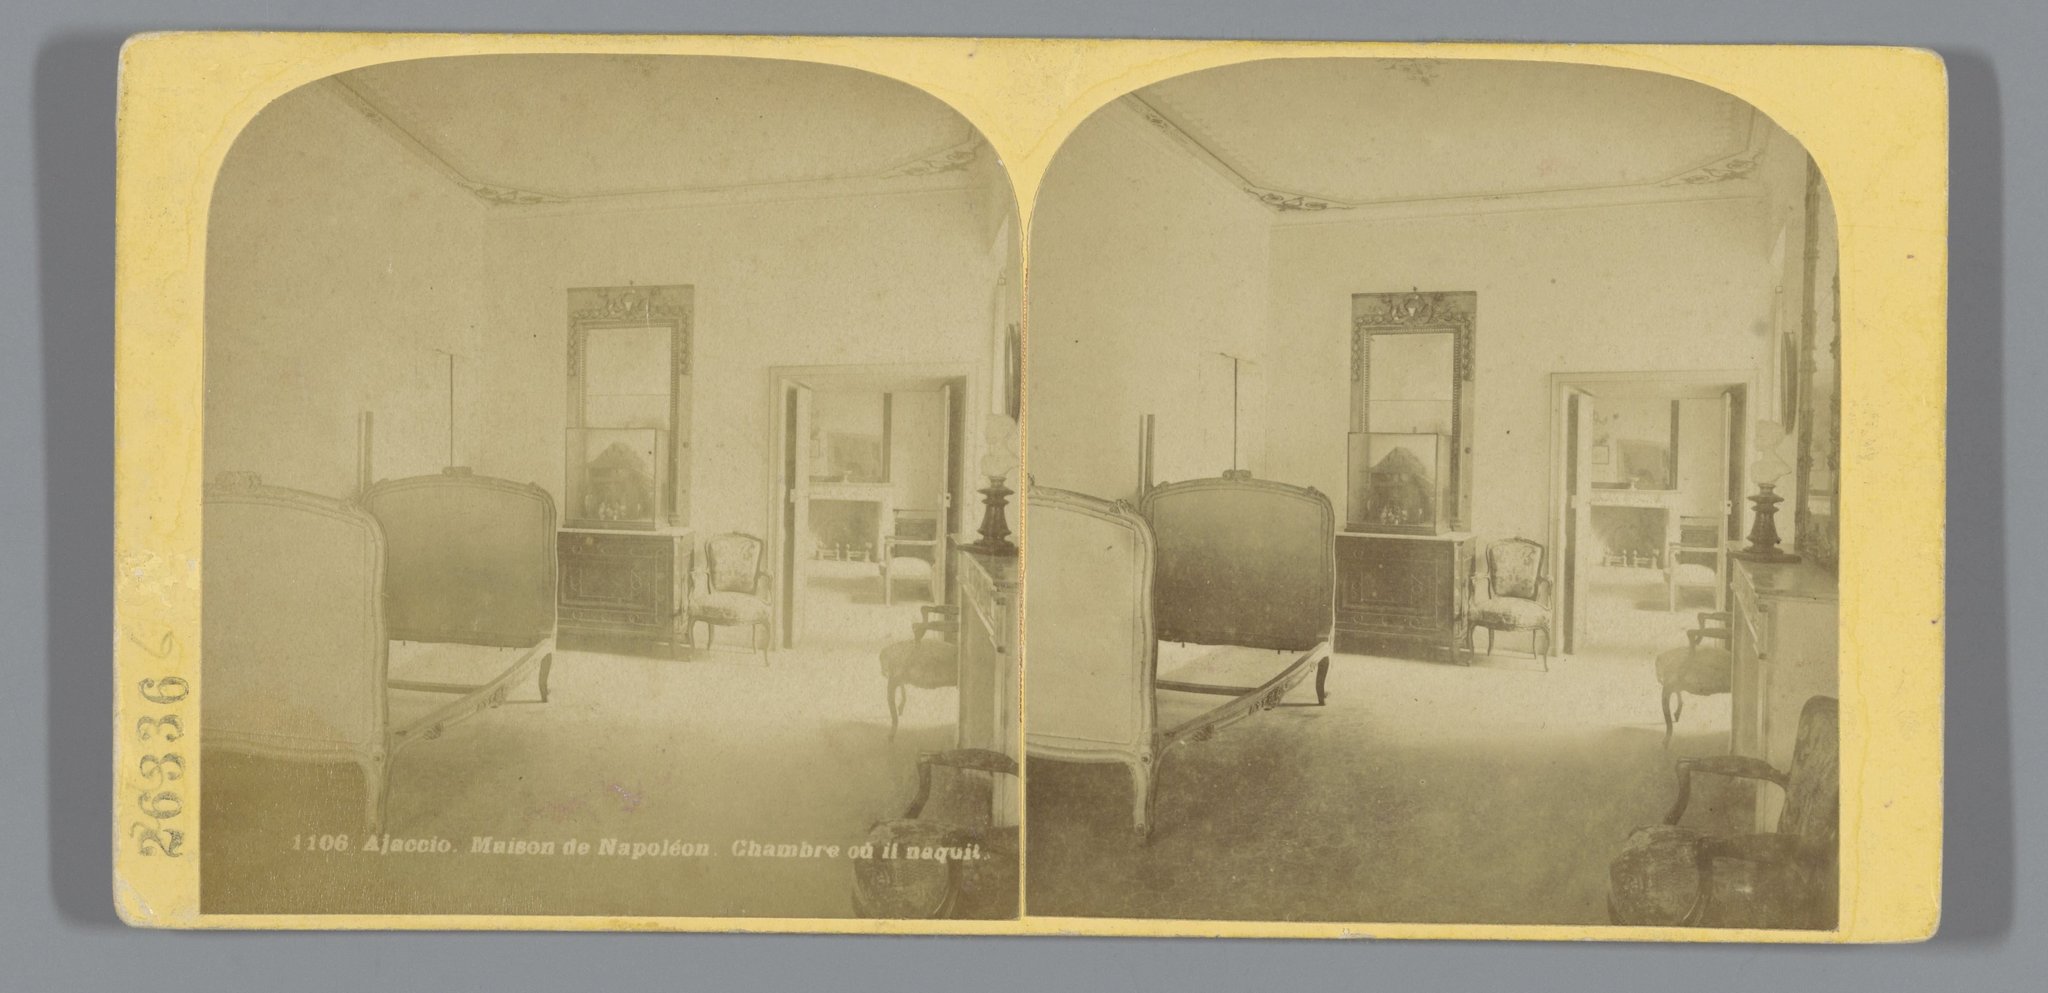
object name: stereograph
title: Geboortekamer van Napoleon Bonaparte te Ajaccio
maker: Anonymous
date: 1865-1885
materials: cardboard, photographic support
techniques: albumen print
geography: ajaccio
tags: interior ~ representation of a building, bedroom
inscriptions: number: ‘1106’, number: ‘26336’